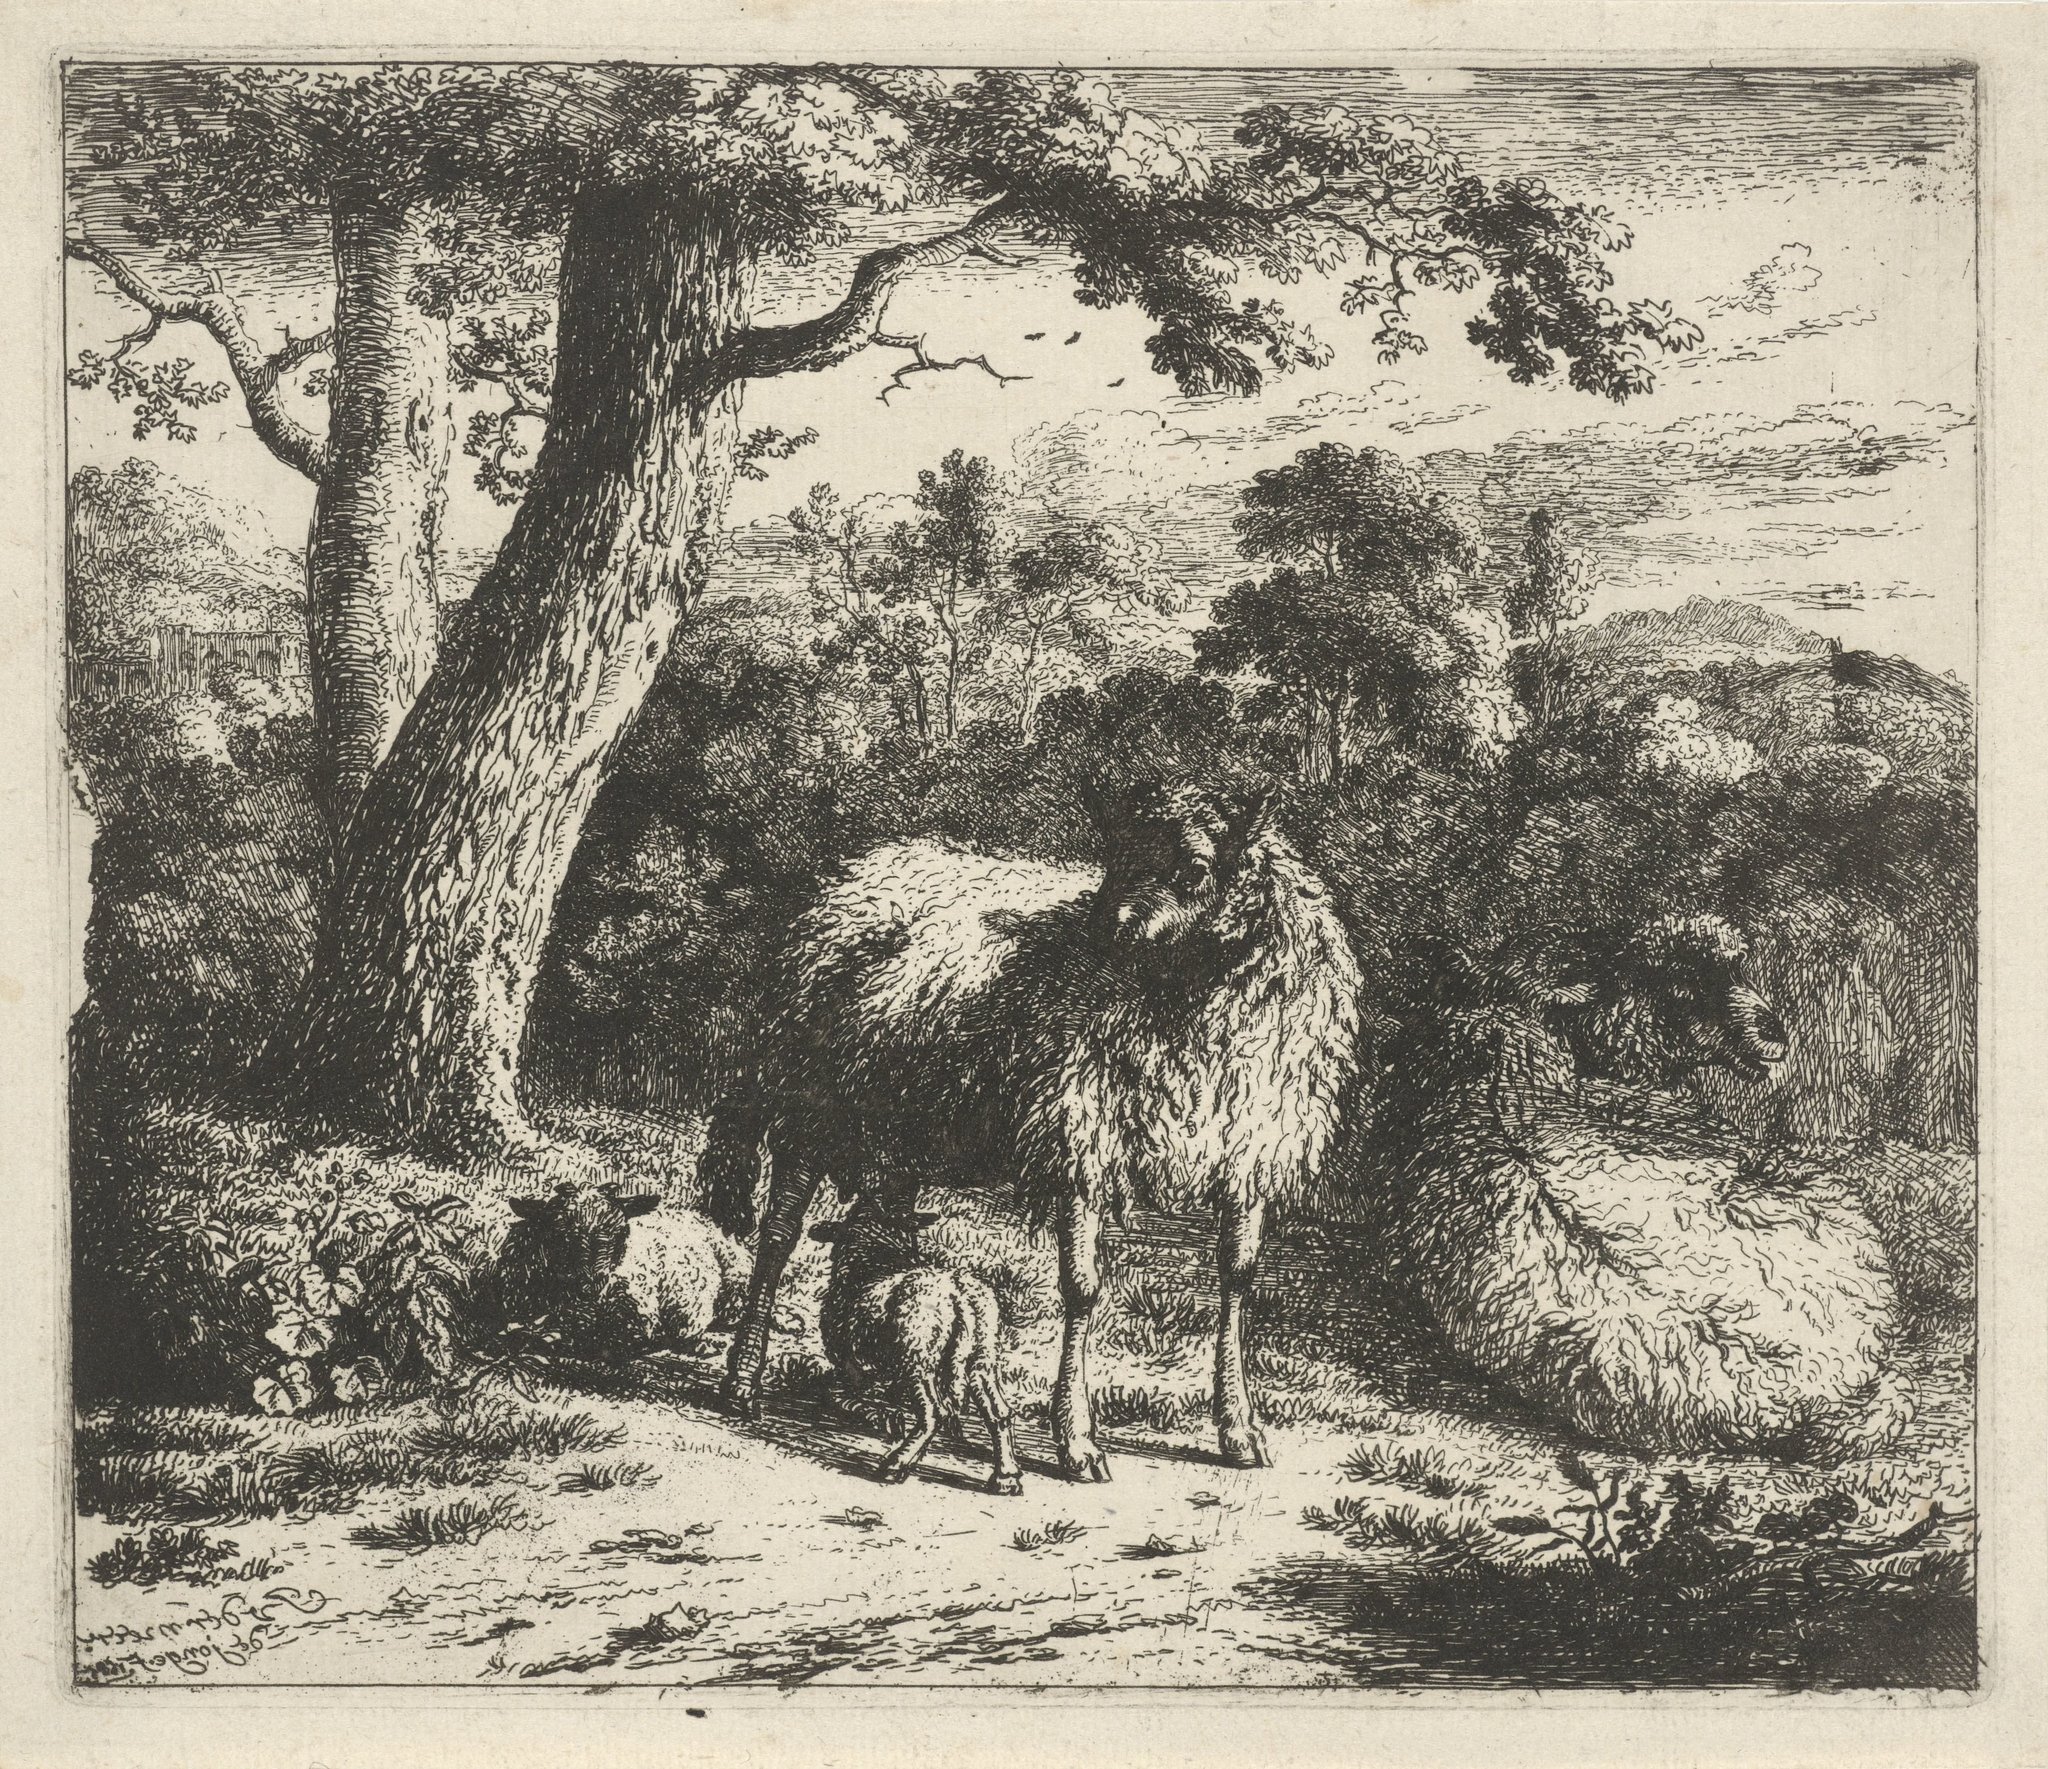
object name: print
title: Staand schaap met twee lammeren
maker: jan van der meer (ii)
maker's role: draughtsman, print maker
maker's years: 1656-1705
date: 1685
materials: paper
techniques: etching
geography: haarlem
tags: sheep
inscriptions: collector's mark: Lugt 240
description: Een staand en een liggend schaap in een landschap. Een lam drinkt bij het staande schaap, een ander lammetje ligt daarachter.